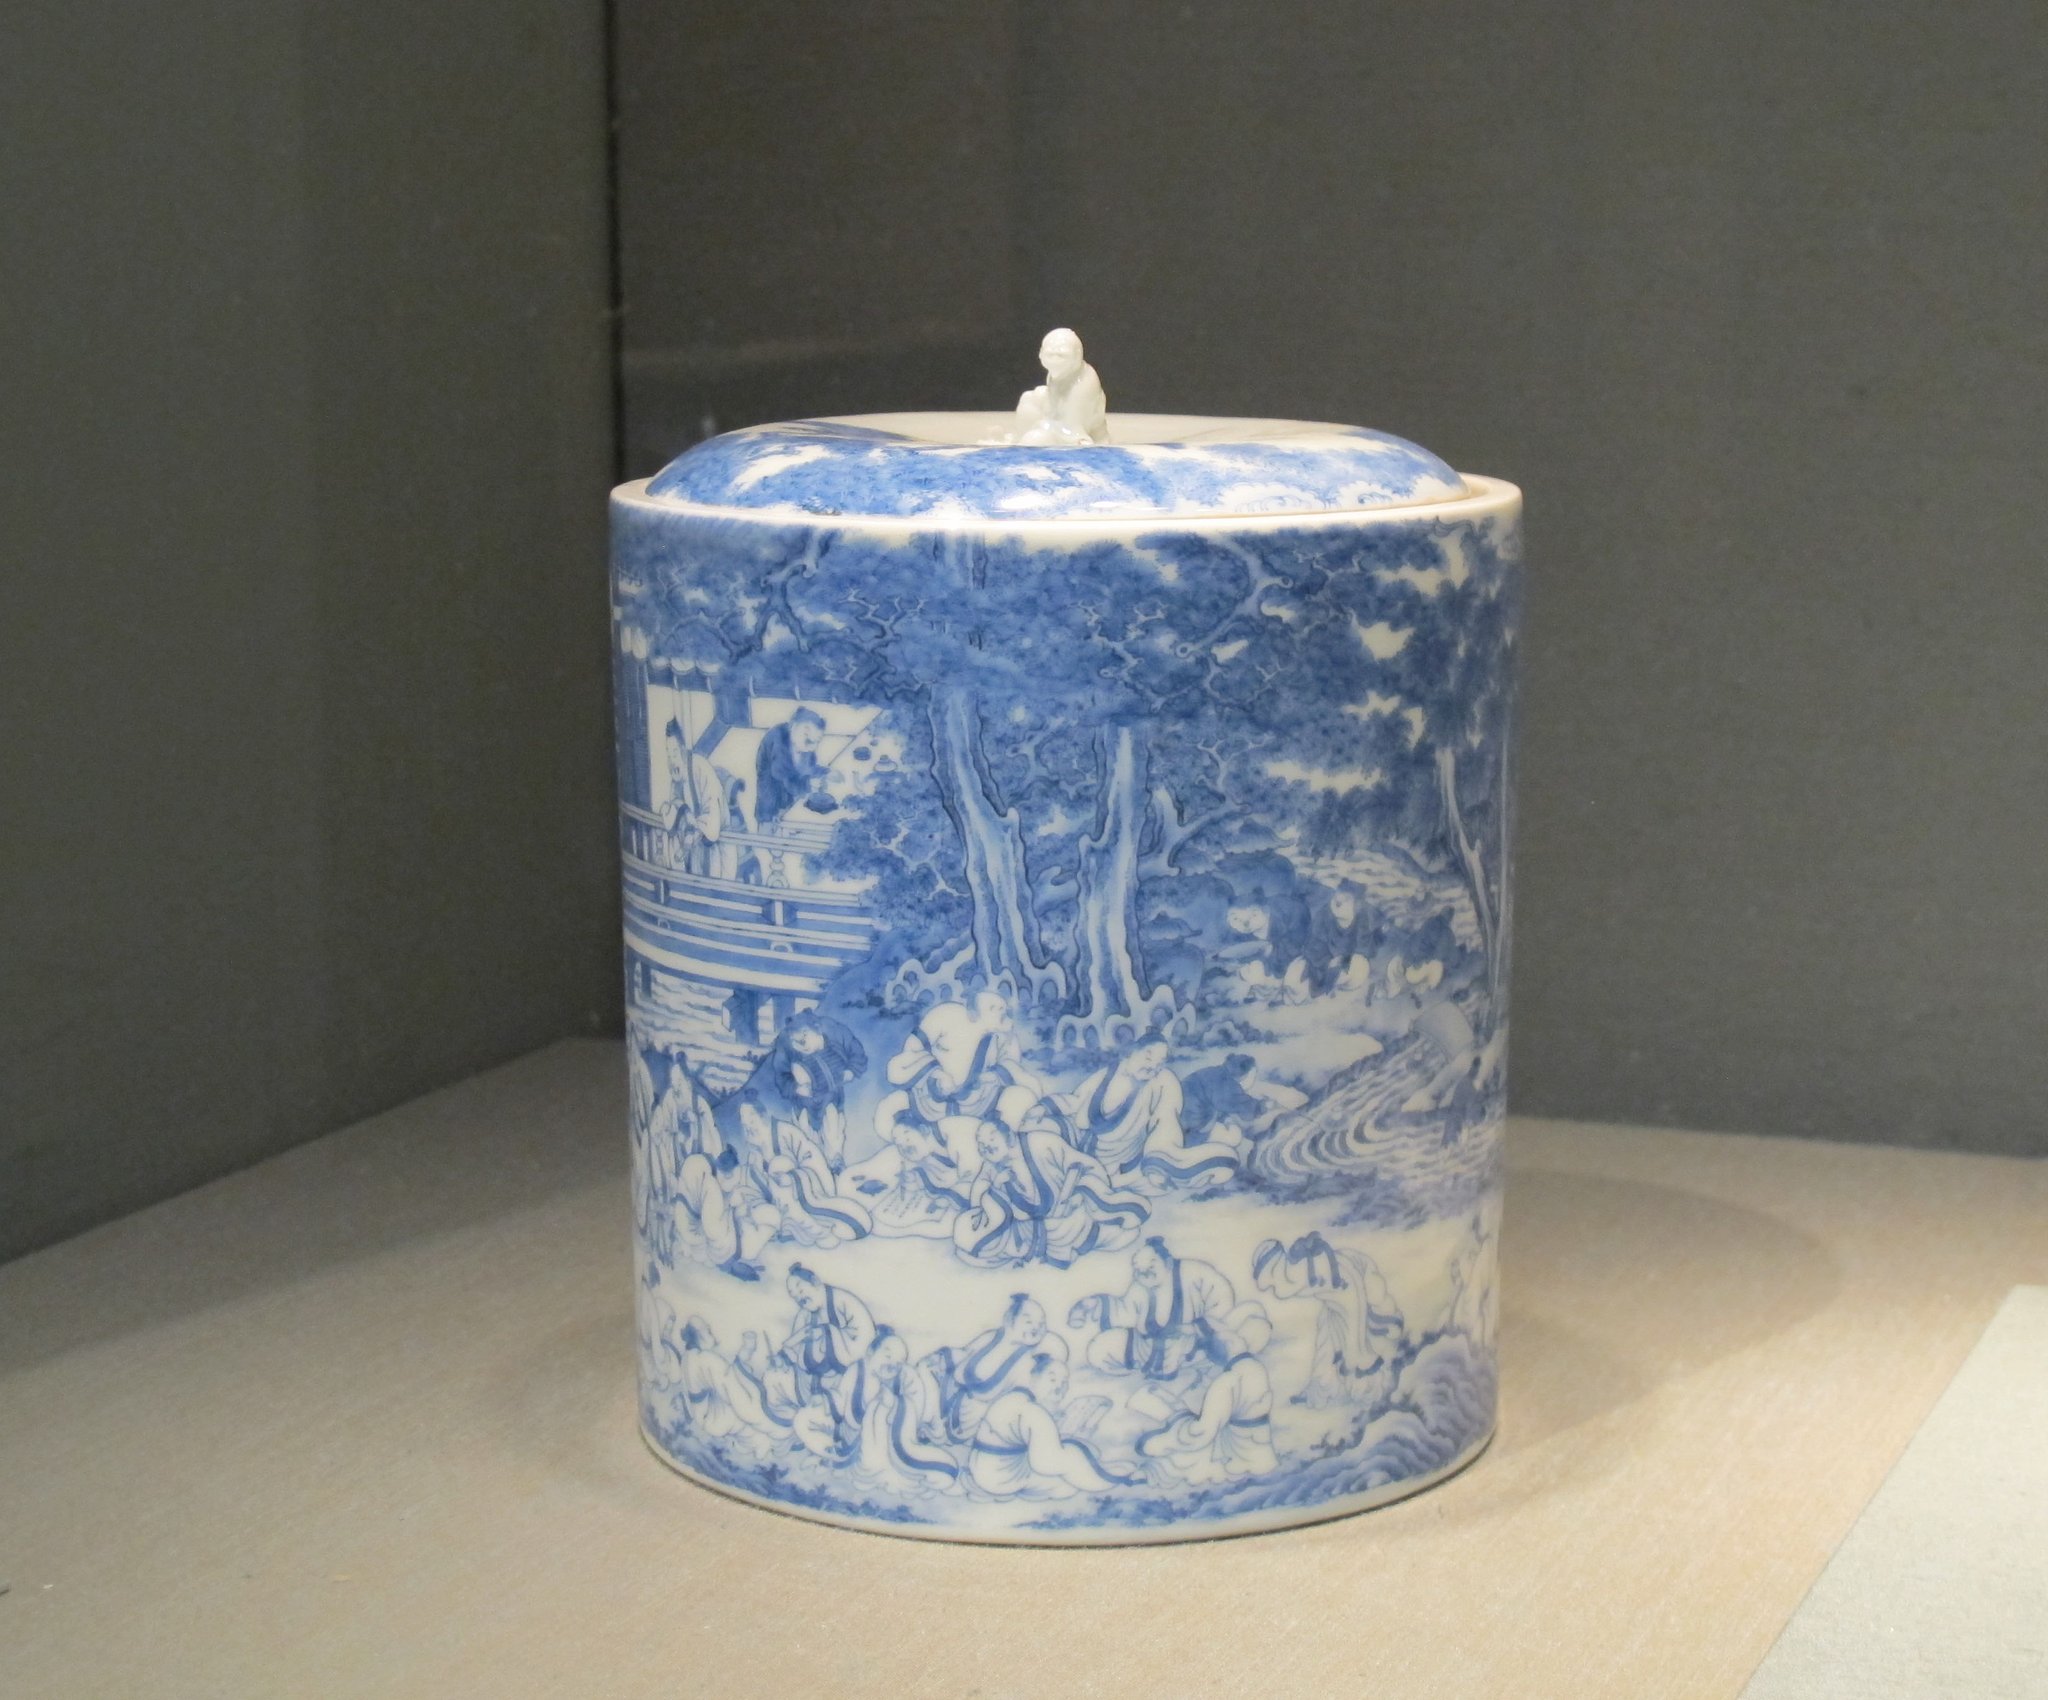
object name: water jar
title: Water Jar with Poetry Gathering at the Orchid Pavilion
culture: japanese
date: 1767-1800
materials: porcelain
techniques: underglaze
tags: men,trees